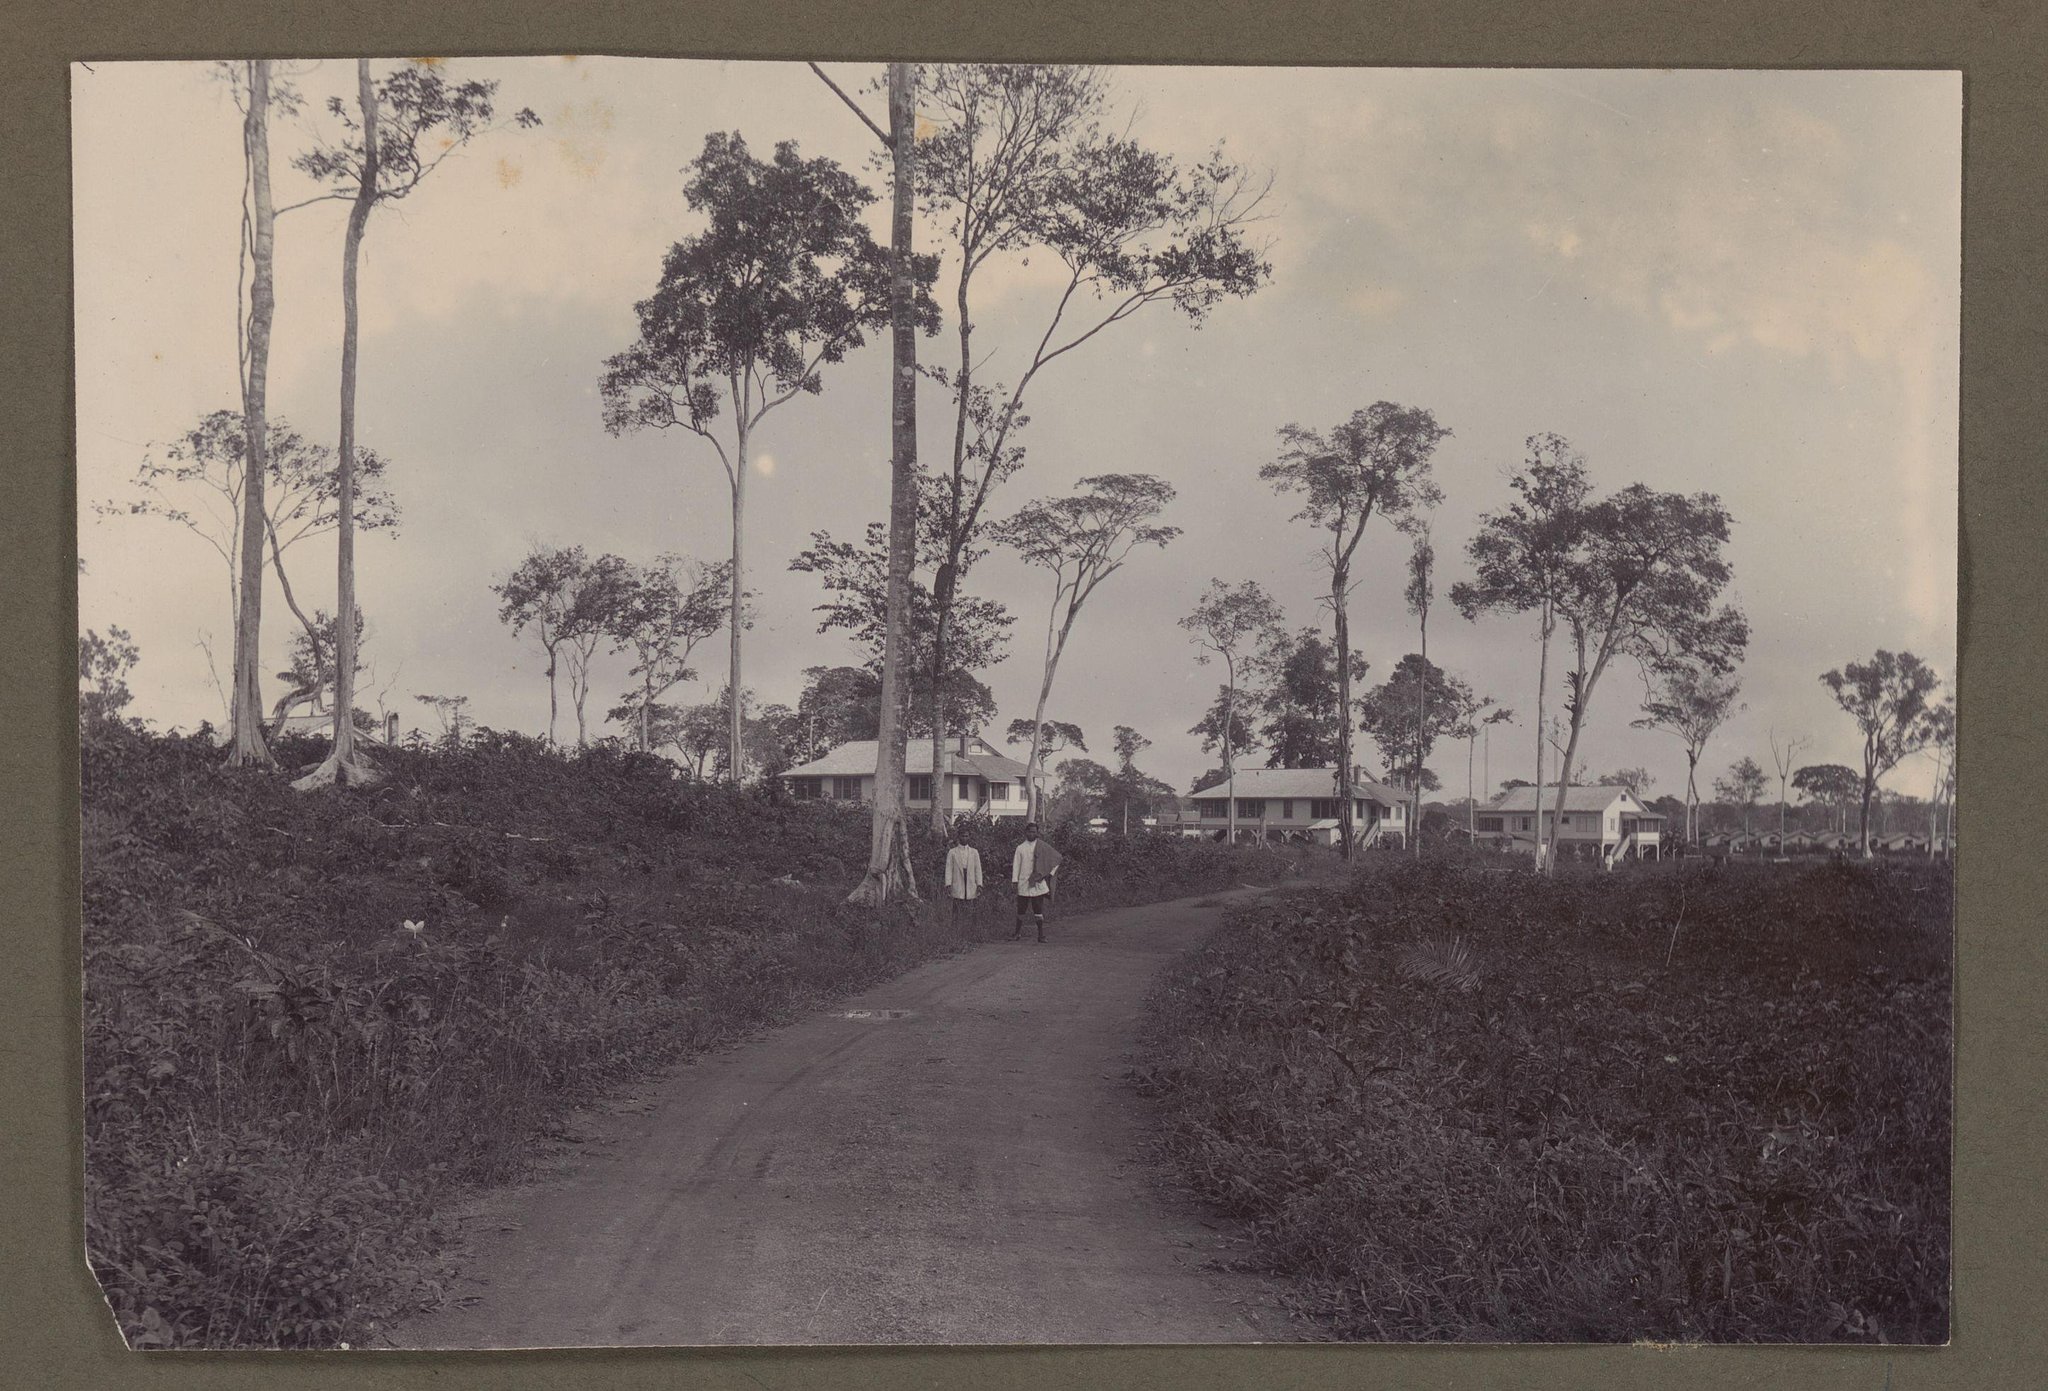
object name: photograph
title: Weg met woningen te Moengo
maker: Anonymous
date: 1925-1927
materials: photographic support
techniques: photography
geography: suriname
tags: jetten, familie, moengo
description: Weg met woningen te Moengo. Foto op een bladzijde van een los albumblad. Onderdeel van het ensemble met foto's van de familie van ingenieur Jetten in de mijnbouwstad Moengo in Suriname.